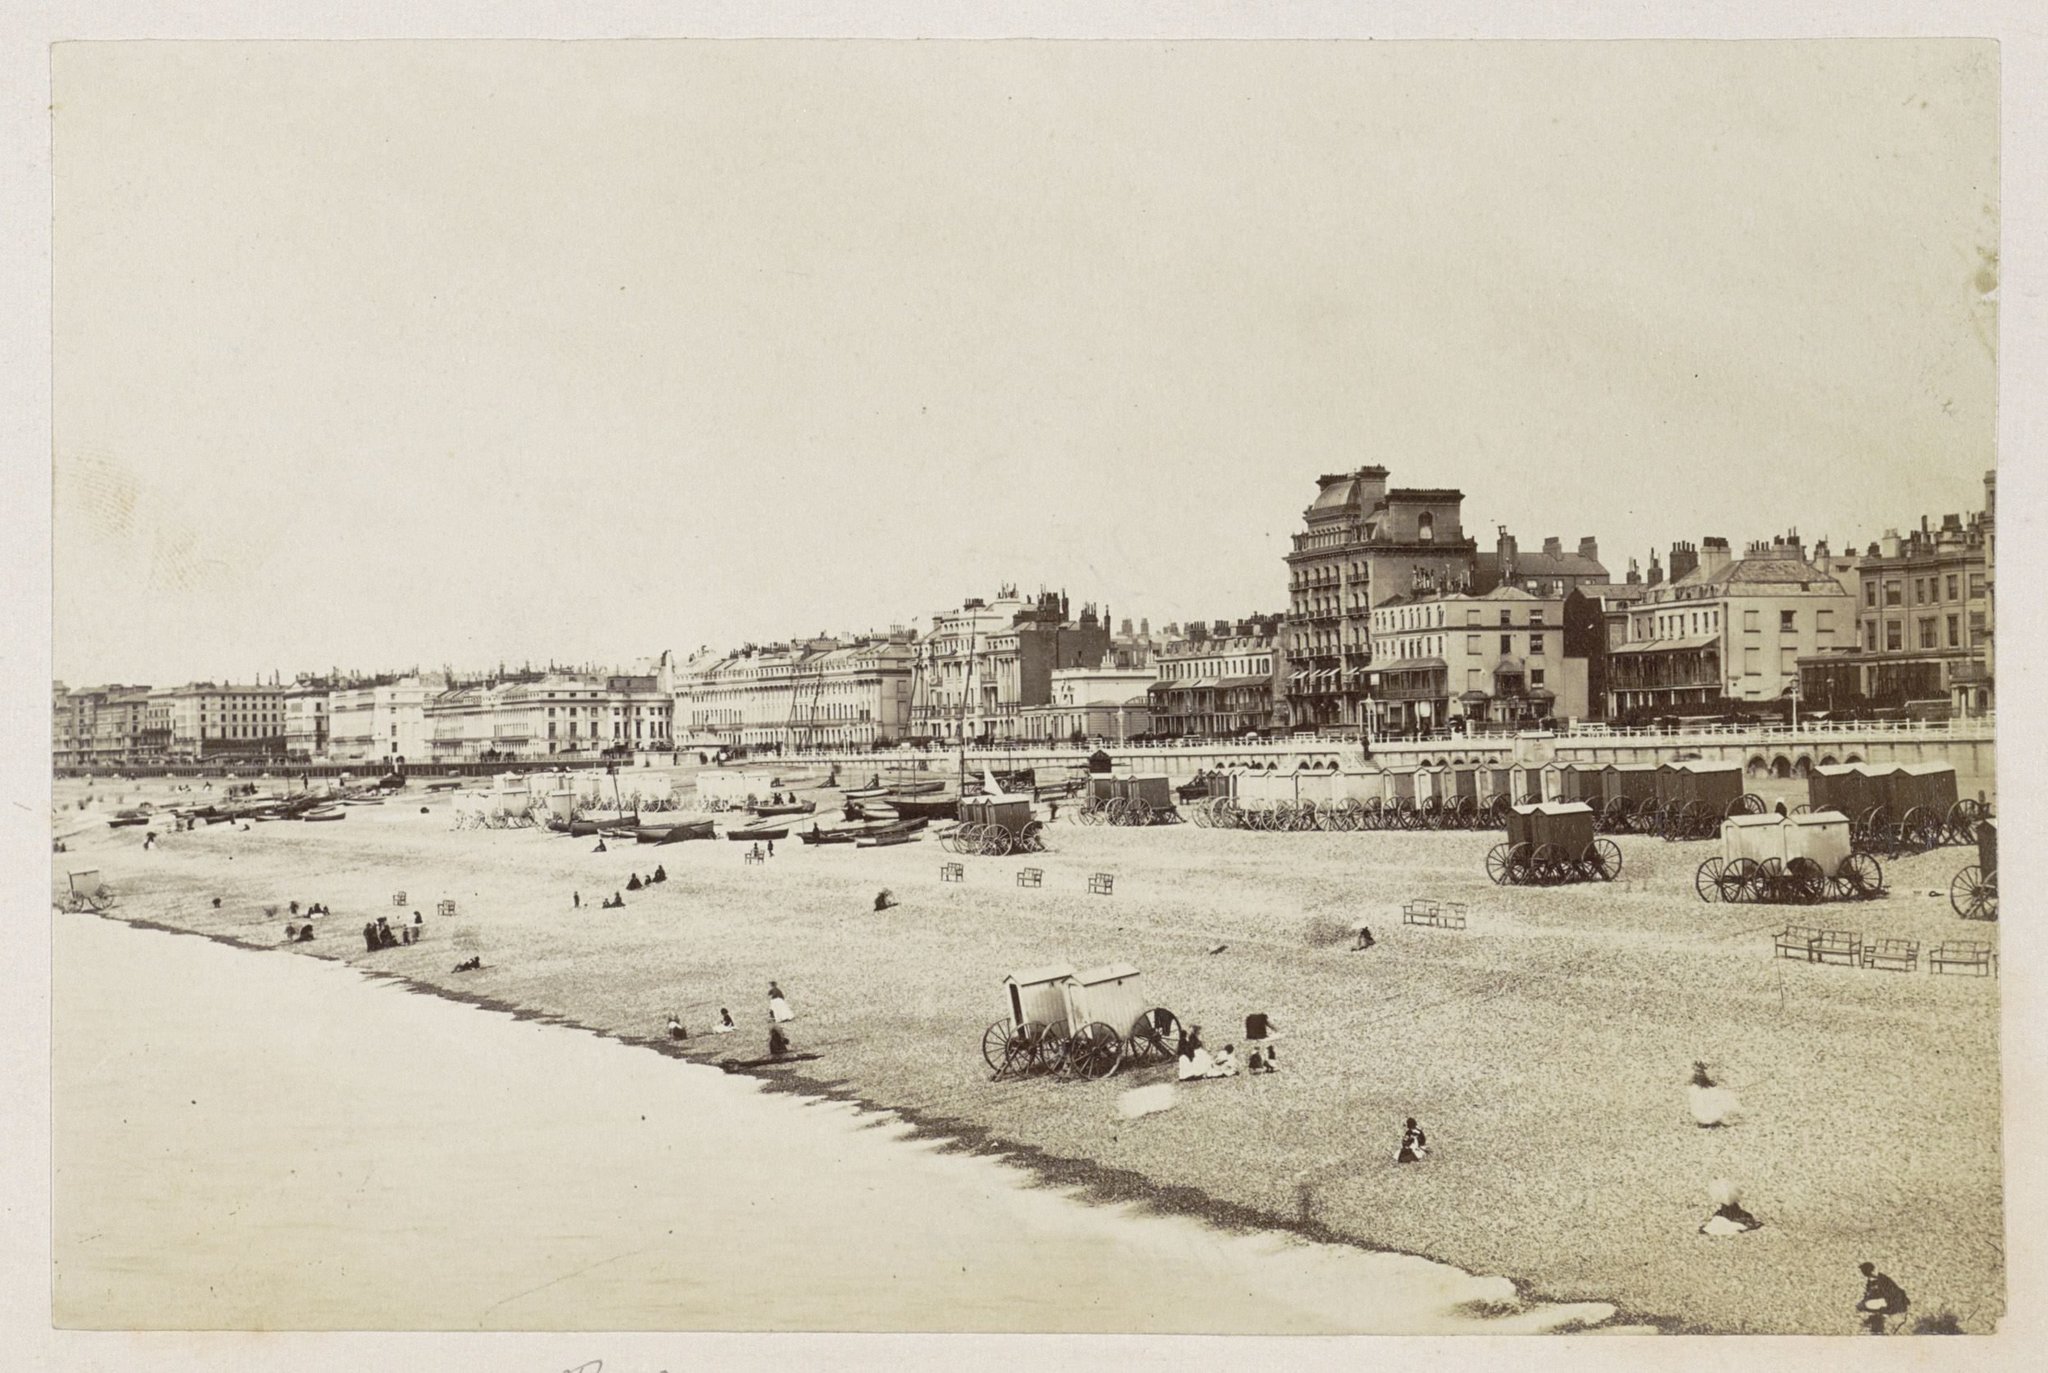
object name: photograph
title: Gebouwen, badgasten en badkoetsen aan het strand van Brighton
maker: Anonymous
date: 1878-1890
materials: photographic support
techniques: albumen print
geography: brighton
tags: four-wheeled, animal-drawn vehicle, e.g.: cab, carriage, coach (+ conveyance for transport of persons), avenue, boulevard, promenade, esplanade (+ city(-scape) with figures, staffage), beach, in or beside the water (on the beach)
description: Onderdeel van Reisalbum Europese steden, vermoedelijk Zweeds.